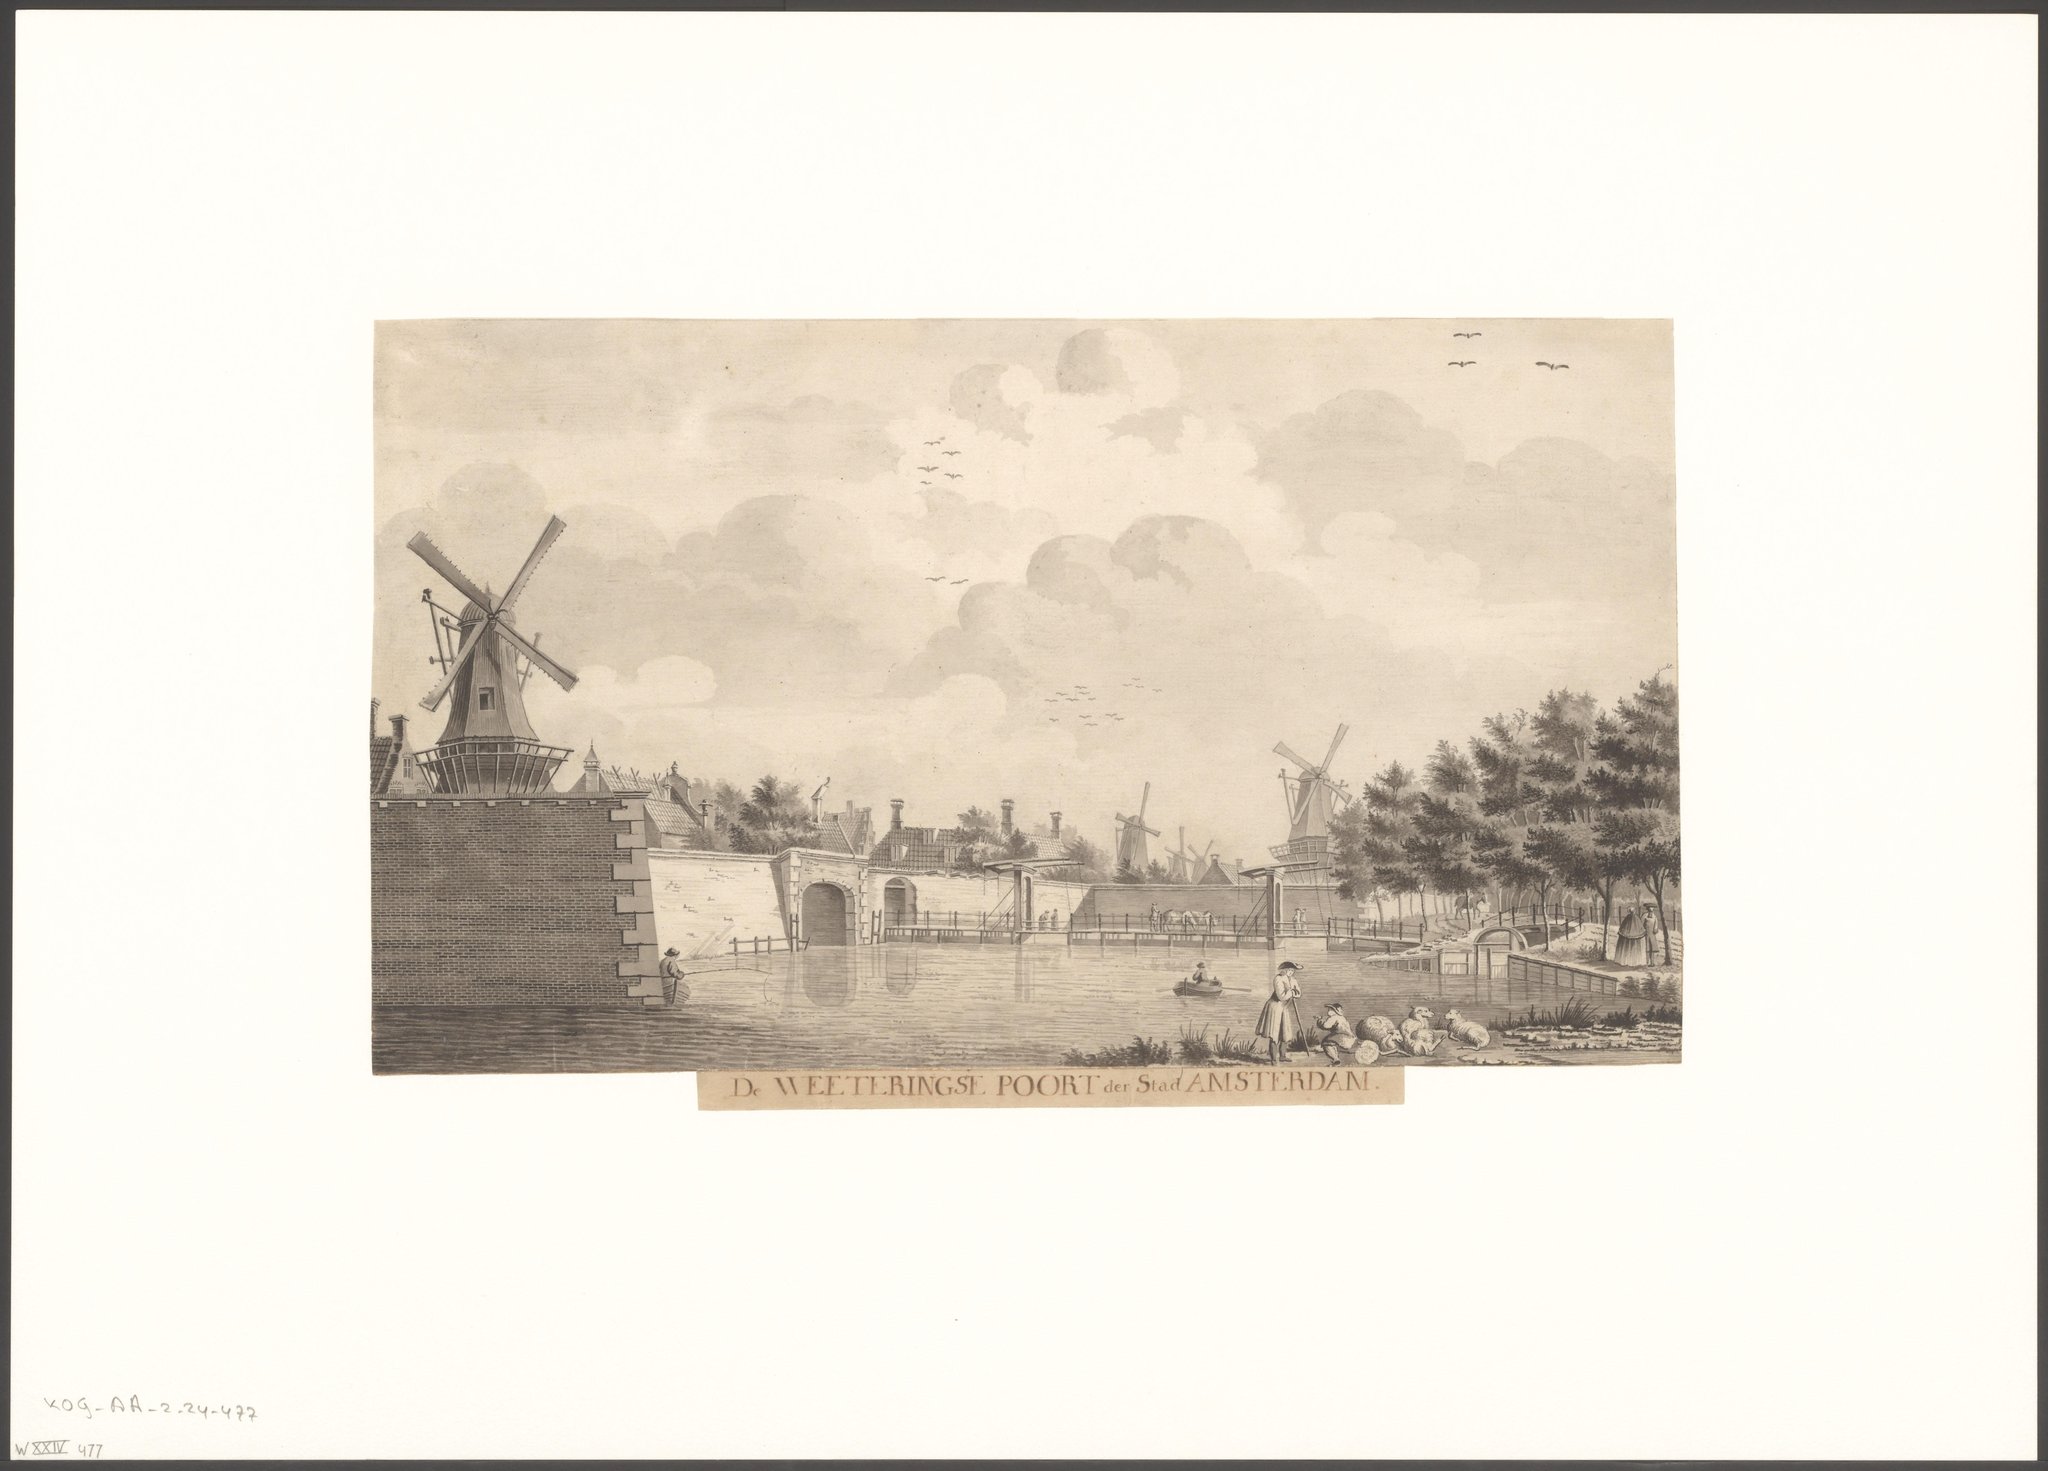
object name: drawing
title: Gezicht op de Weteringpoort vanaf het Singel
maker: dirk verrijk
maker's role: draughtsman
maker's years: 1734-1786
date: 1744-1786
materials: ink, paper, pencil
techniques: brush, pen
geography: amsterdam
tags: city-view in general; 'veduta', canal, windmill in landscape, bridge in city across river, canal, etc., city-gate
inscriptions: inscription: ‘De Weeteringse Poort der Stad Amsterdam.’, collector's mark: Lugt 800a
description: Tekening binnen de Atlas Van Eck ingedeeld op wijknummer 24.